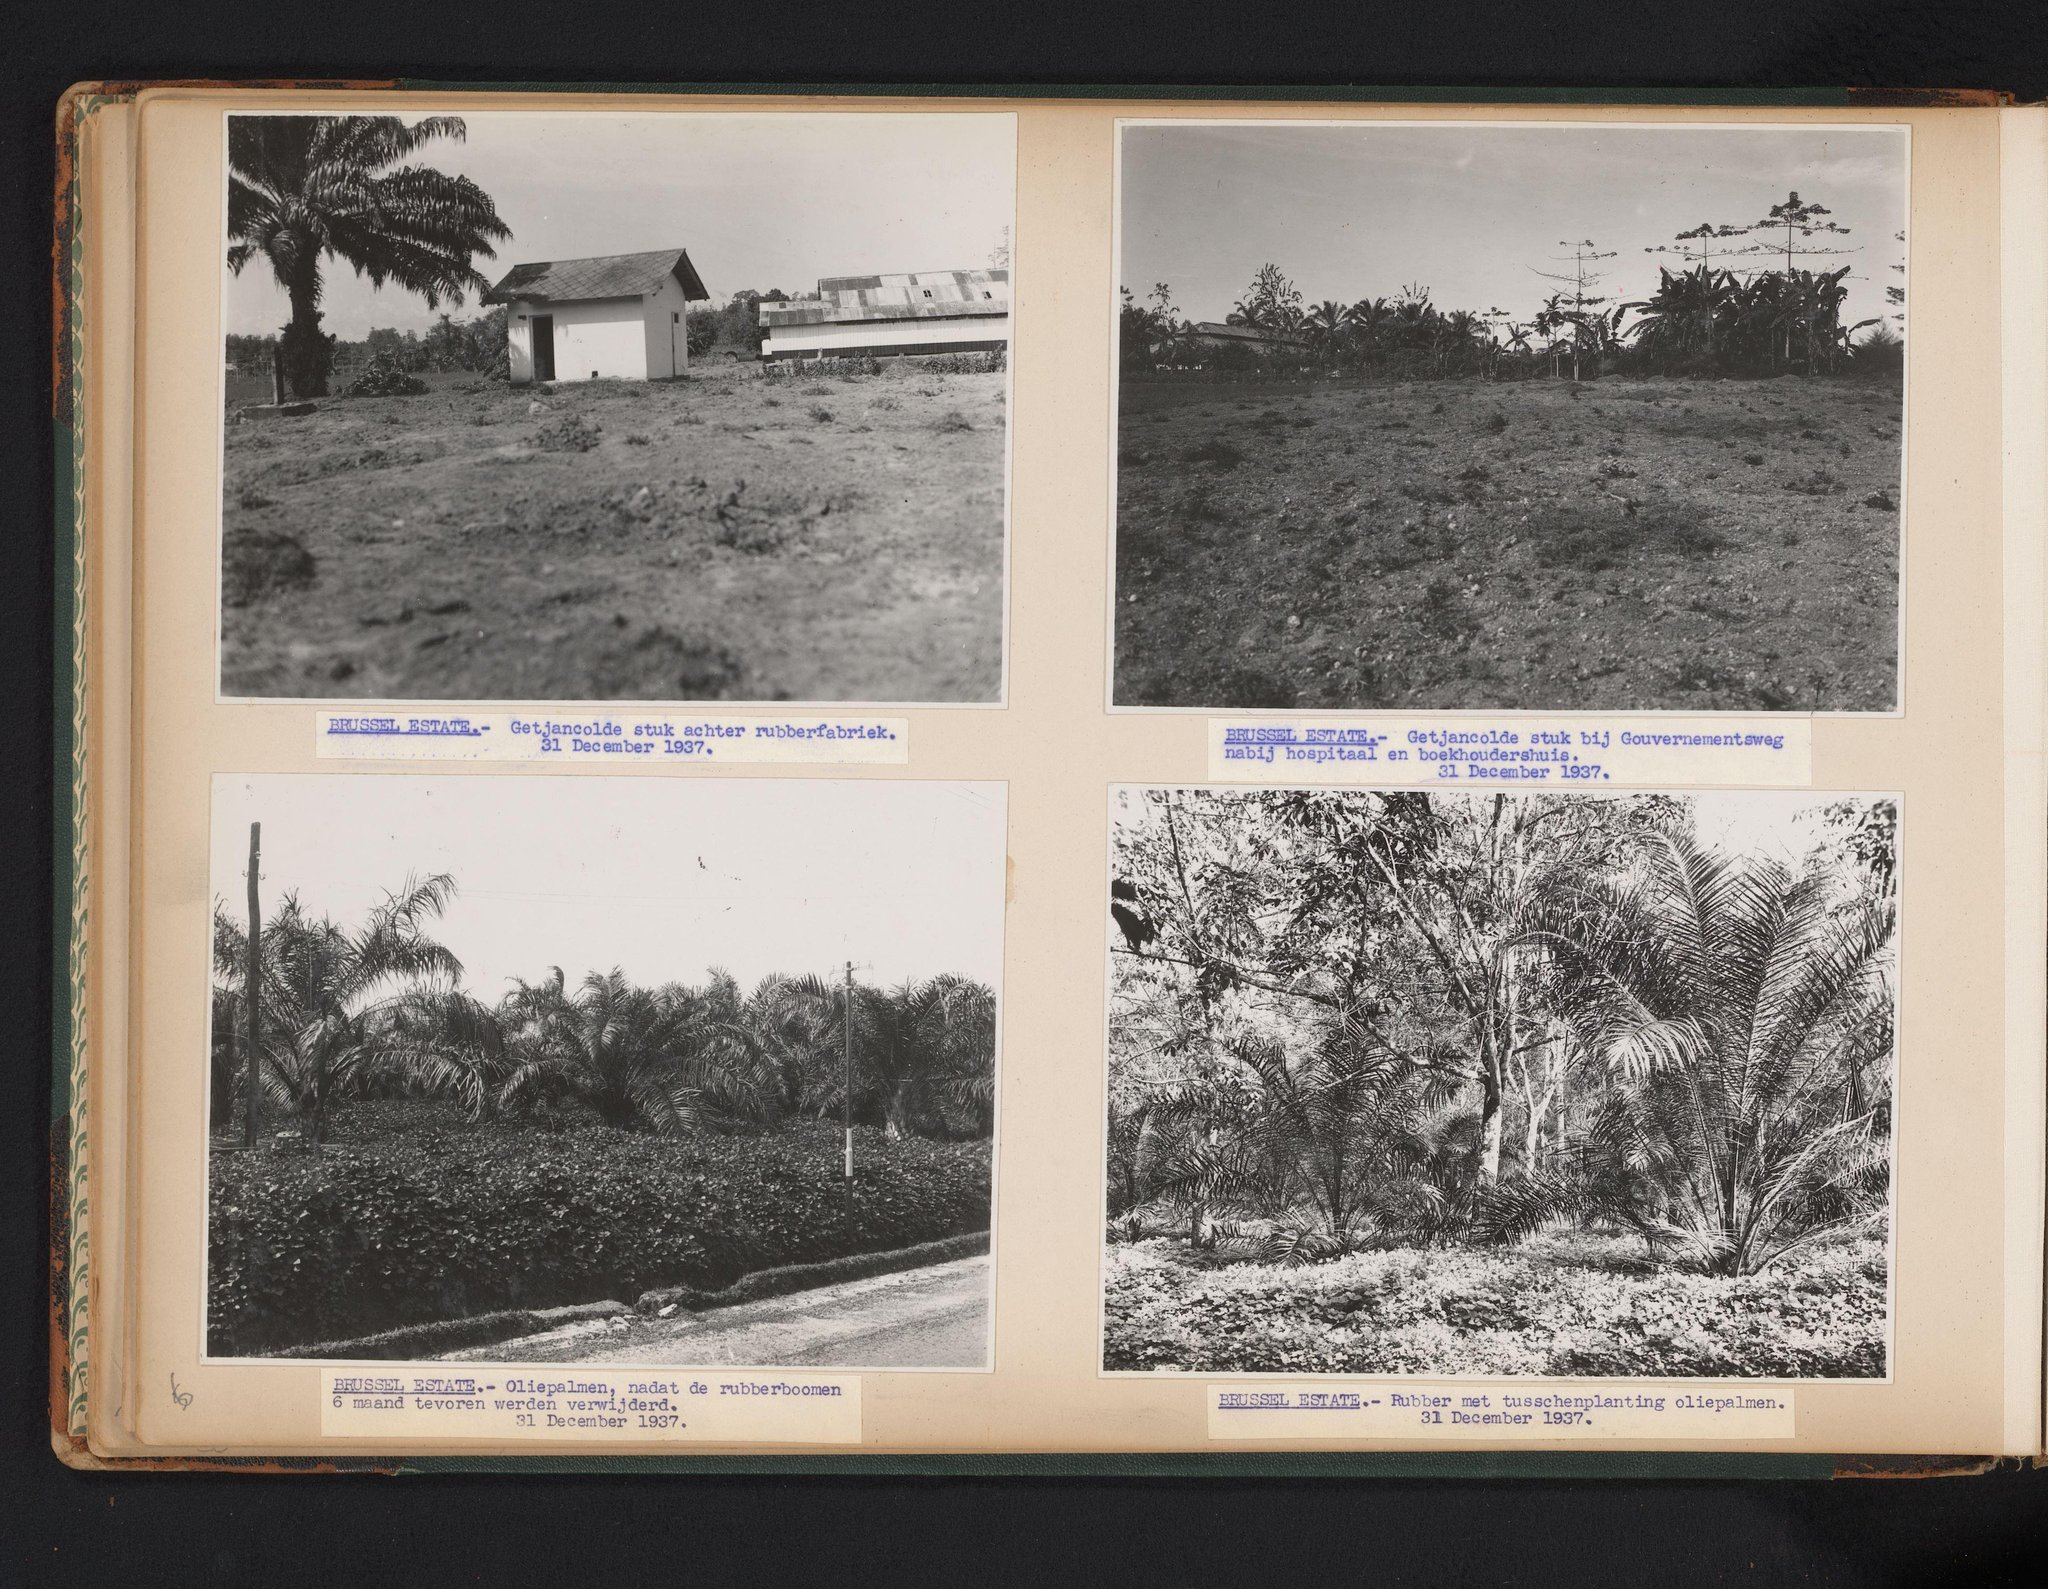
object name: album leaf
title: Oliepalmen op Brussel, 1937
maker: Anonymous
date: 1912-1937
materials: cardboard, photographic support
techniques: gelatin silver print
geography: sumatra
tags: plantation, (non-fruit) products of plants or trees: palm oil, sumatra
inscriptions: inscription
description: Blad met vier foto's van oliepalmen en ontginning op Brussel, 1937. Met etiketten met onderschriften onder de foto's. Onderdeel van het fotoalbum over de plantages Pernantian en Brussel van de Sumatra Caoutchouc Maatschappij op de Oostkust van Sumatra in de jaren 1935-1939.